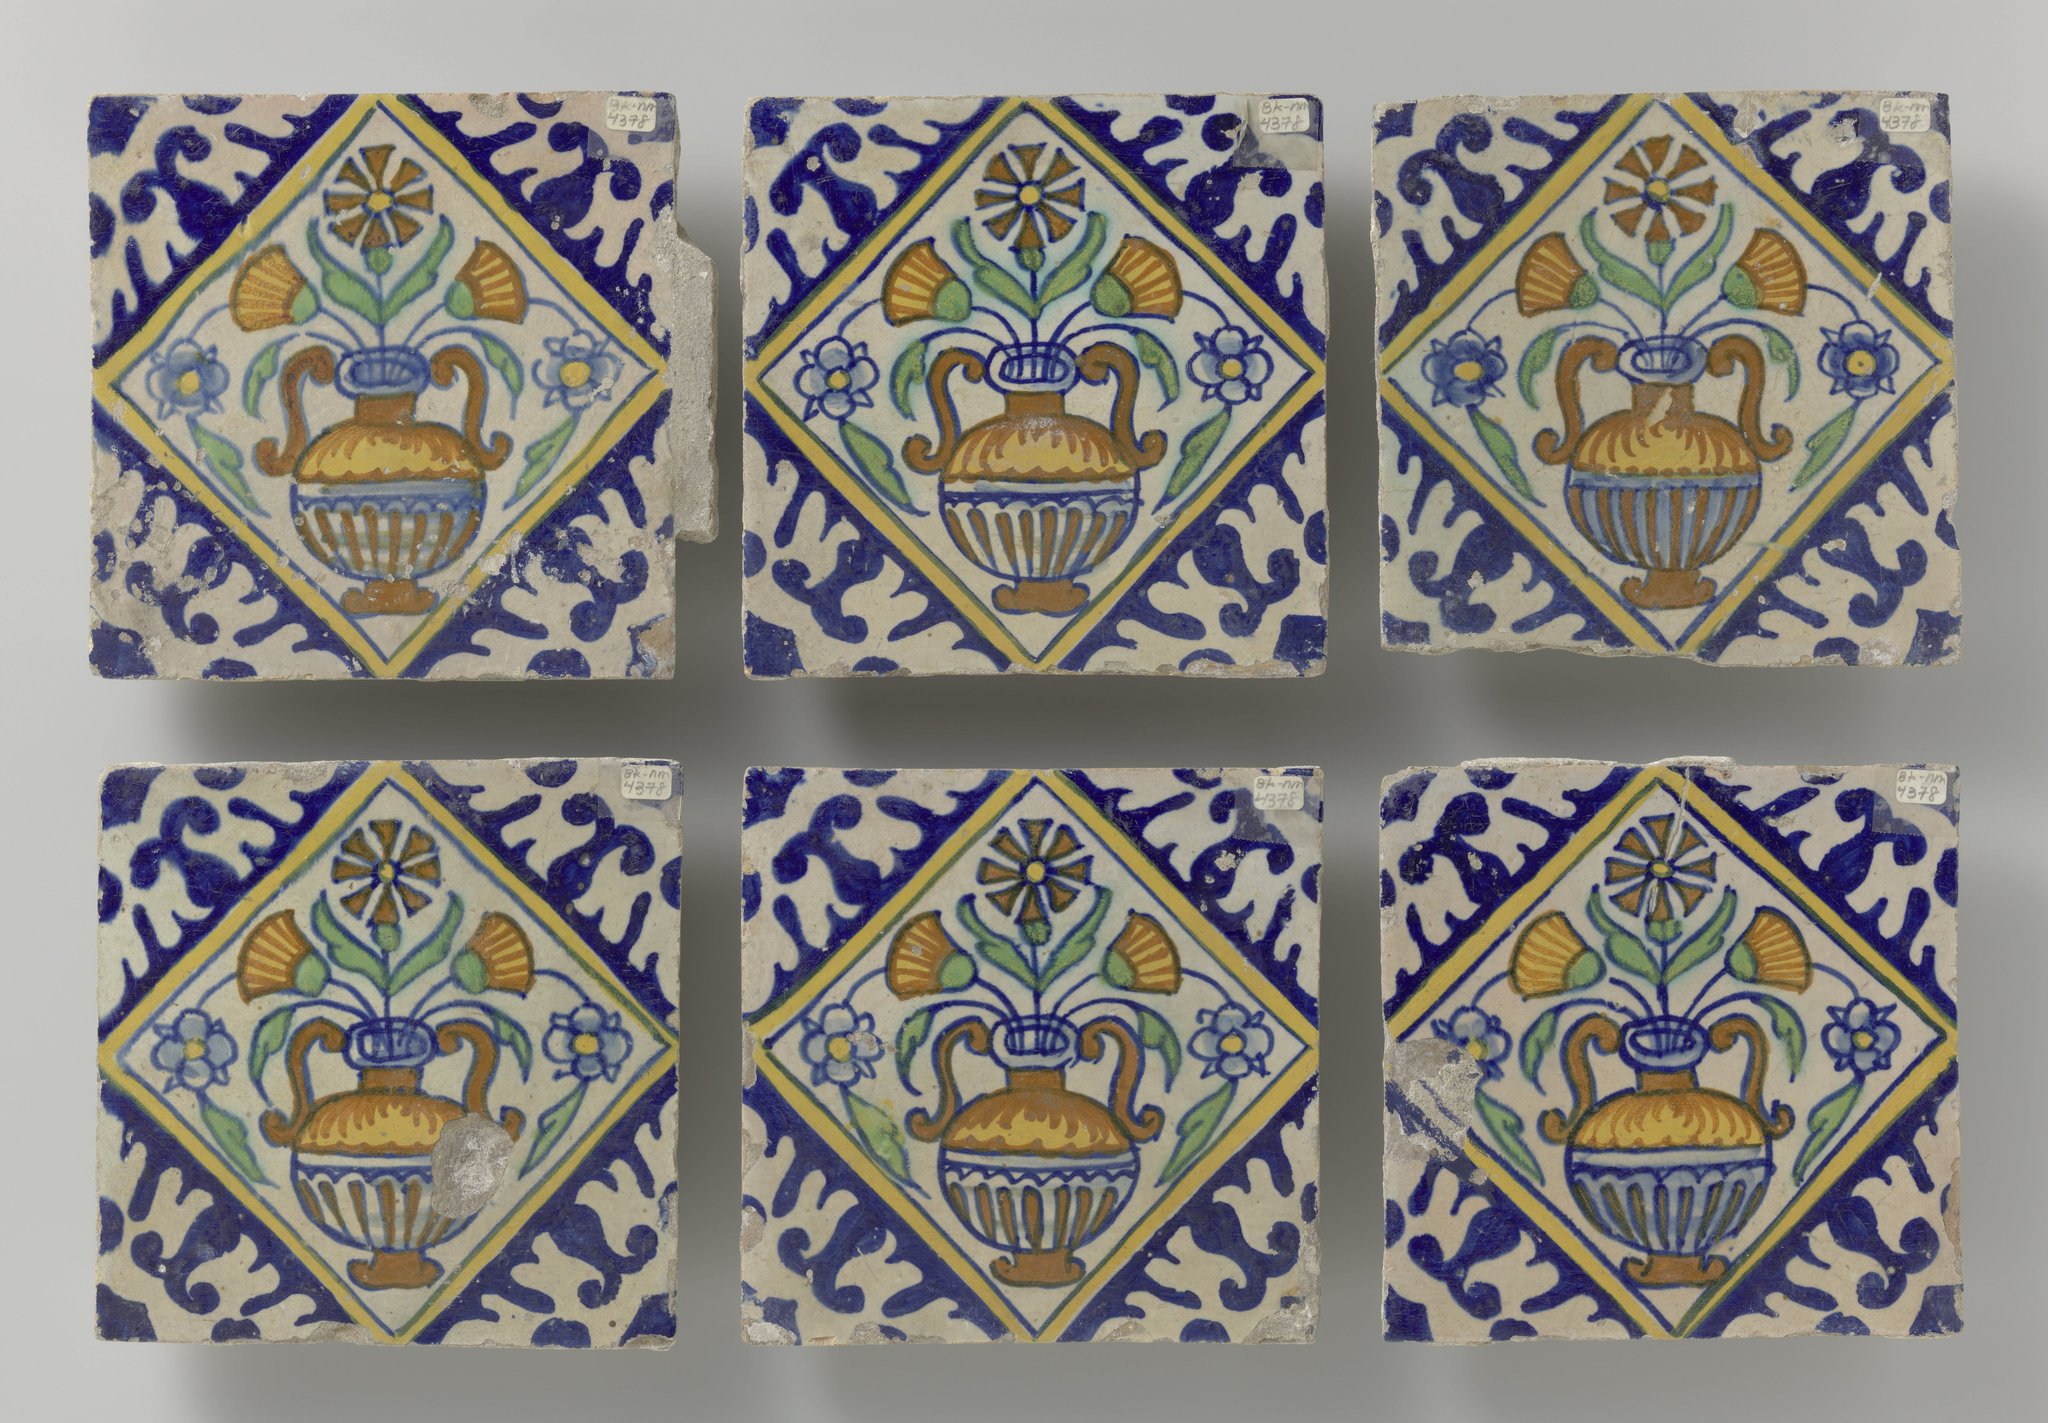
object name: pompadourtegel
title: Acht pompadourtegels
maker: Anonymous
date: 1615-1635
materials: earthenware, glaze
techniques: maiolica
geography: netherlands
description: Acht pompadourtegels met een veelkleurig (blauw, groen, geel en oranje) geschilderde bloempot binnen een vierpas. In de hoeken, ornament in vultechniek.